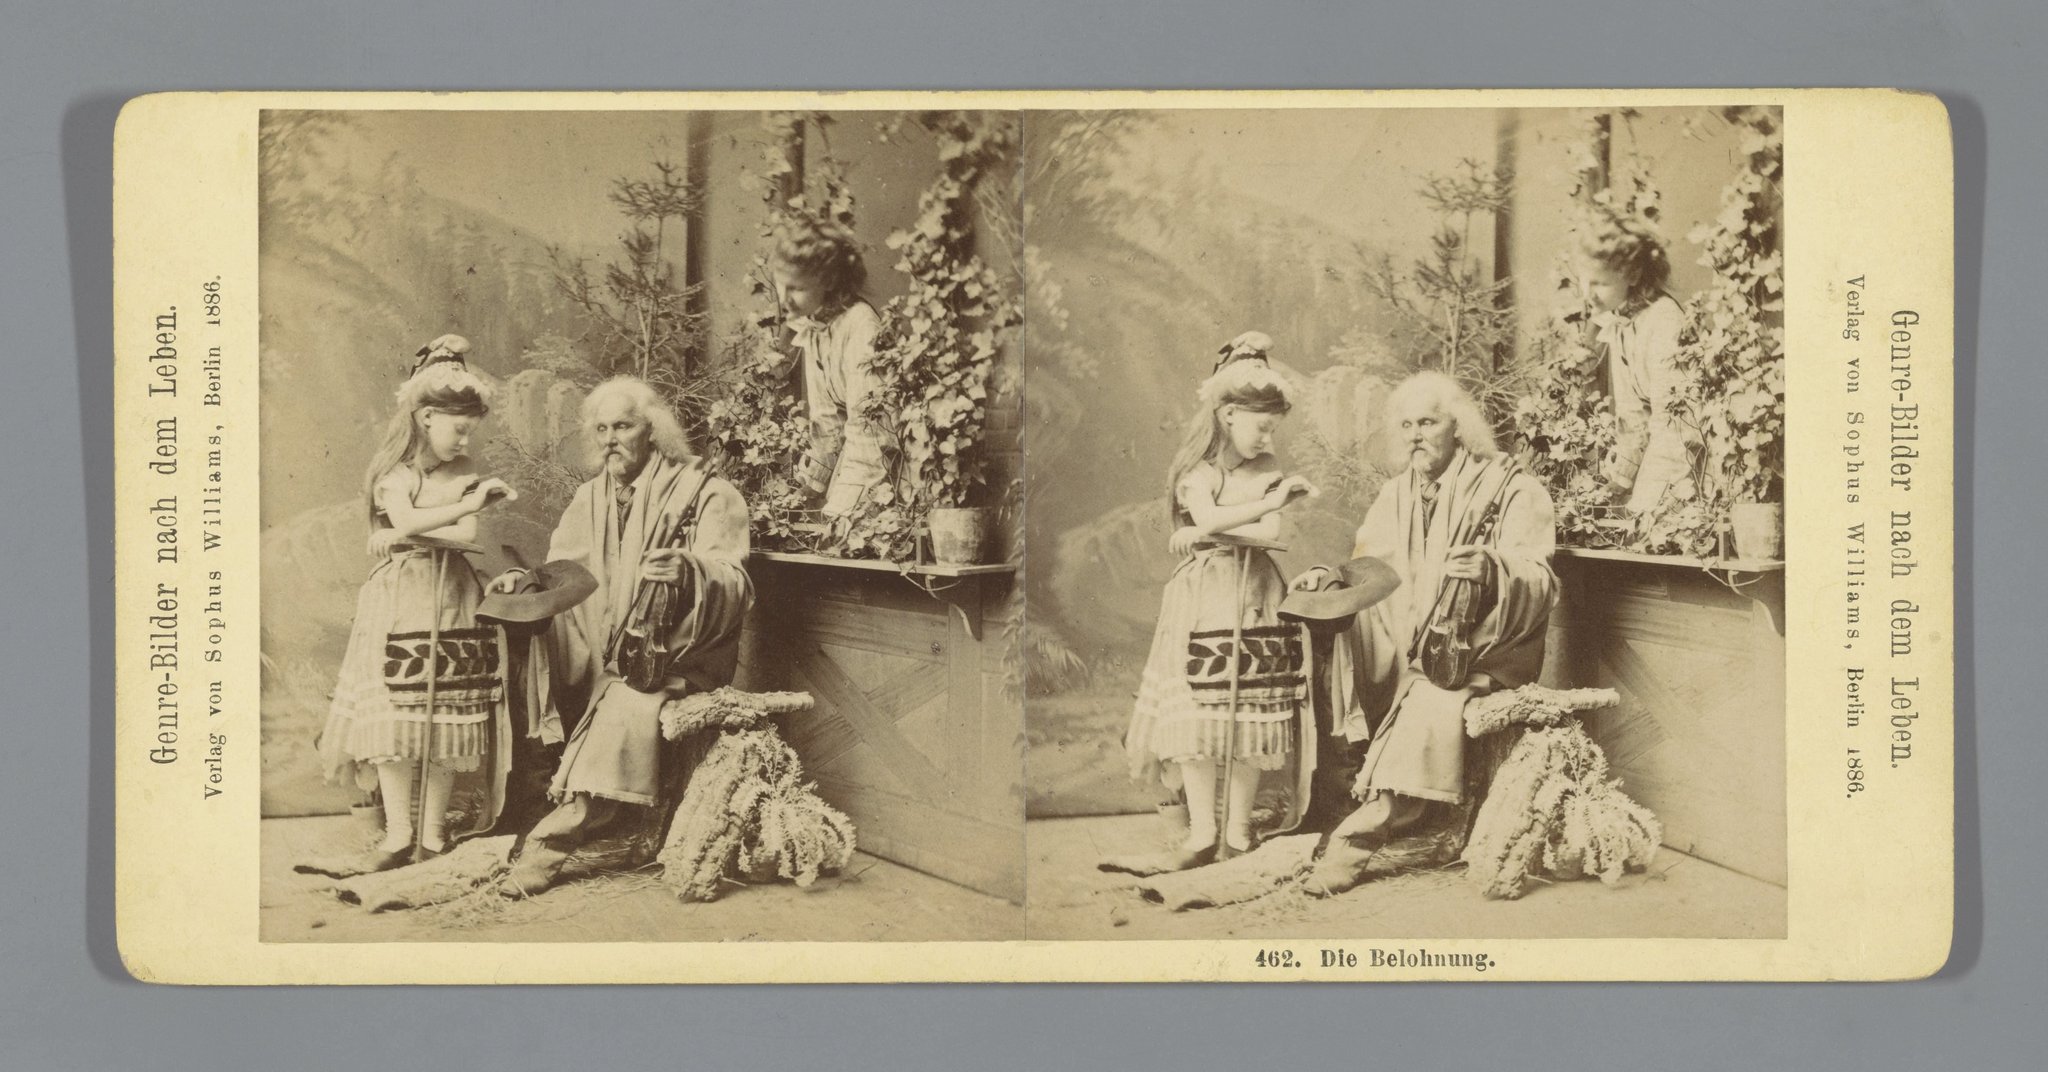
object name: stereograph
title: Meisje werpt munt in hoed van muzikant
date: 1886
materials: cardboard, photographic support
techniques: albumen print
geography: berlin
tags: musician, folk costume, regional costume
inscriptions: number: ‘462’